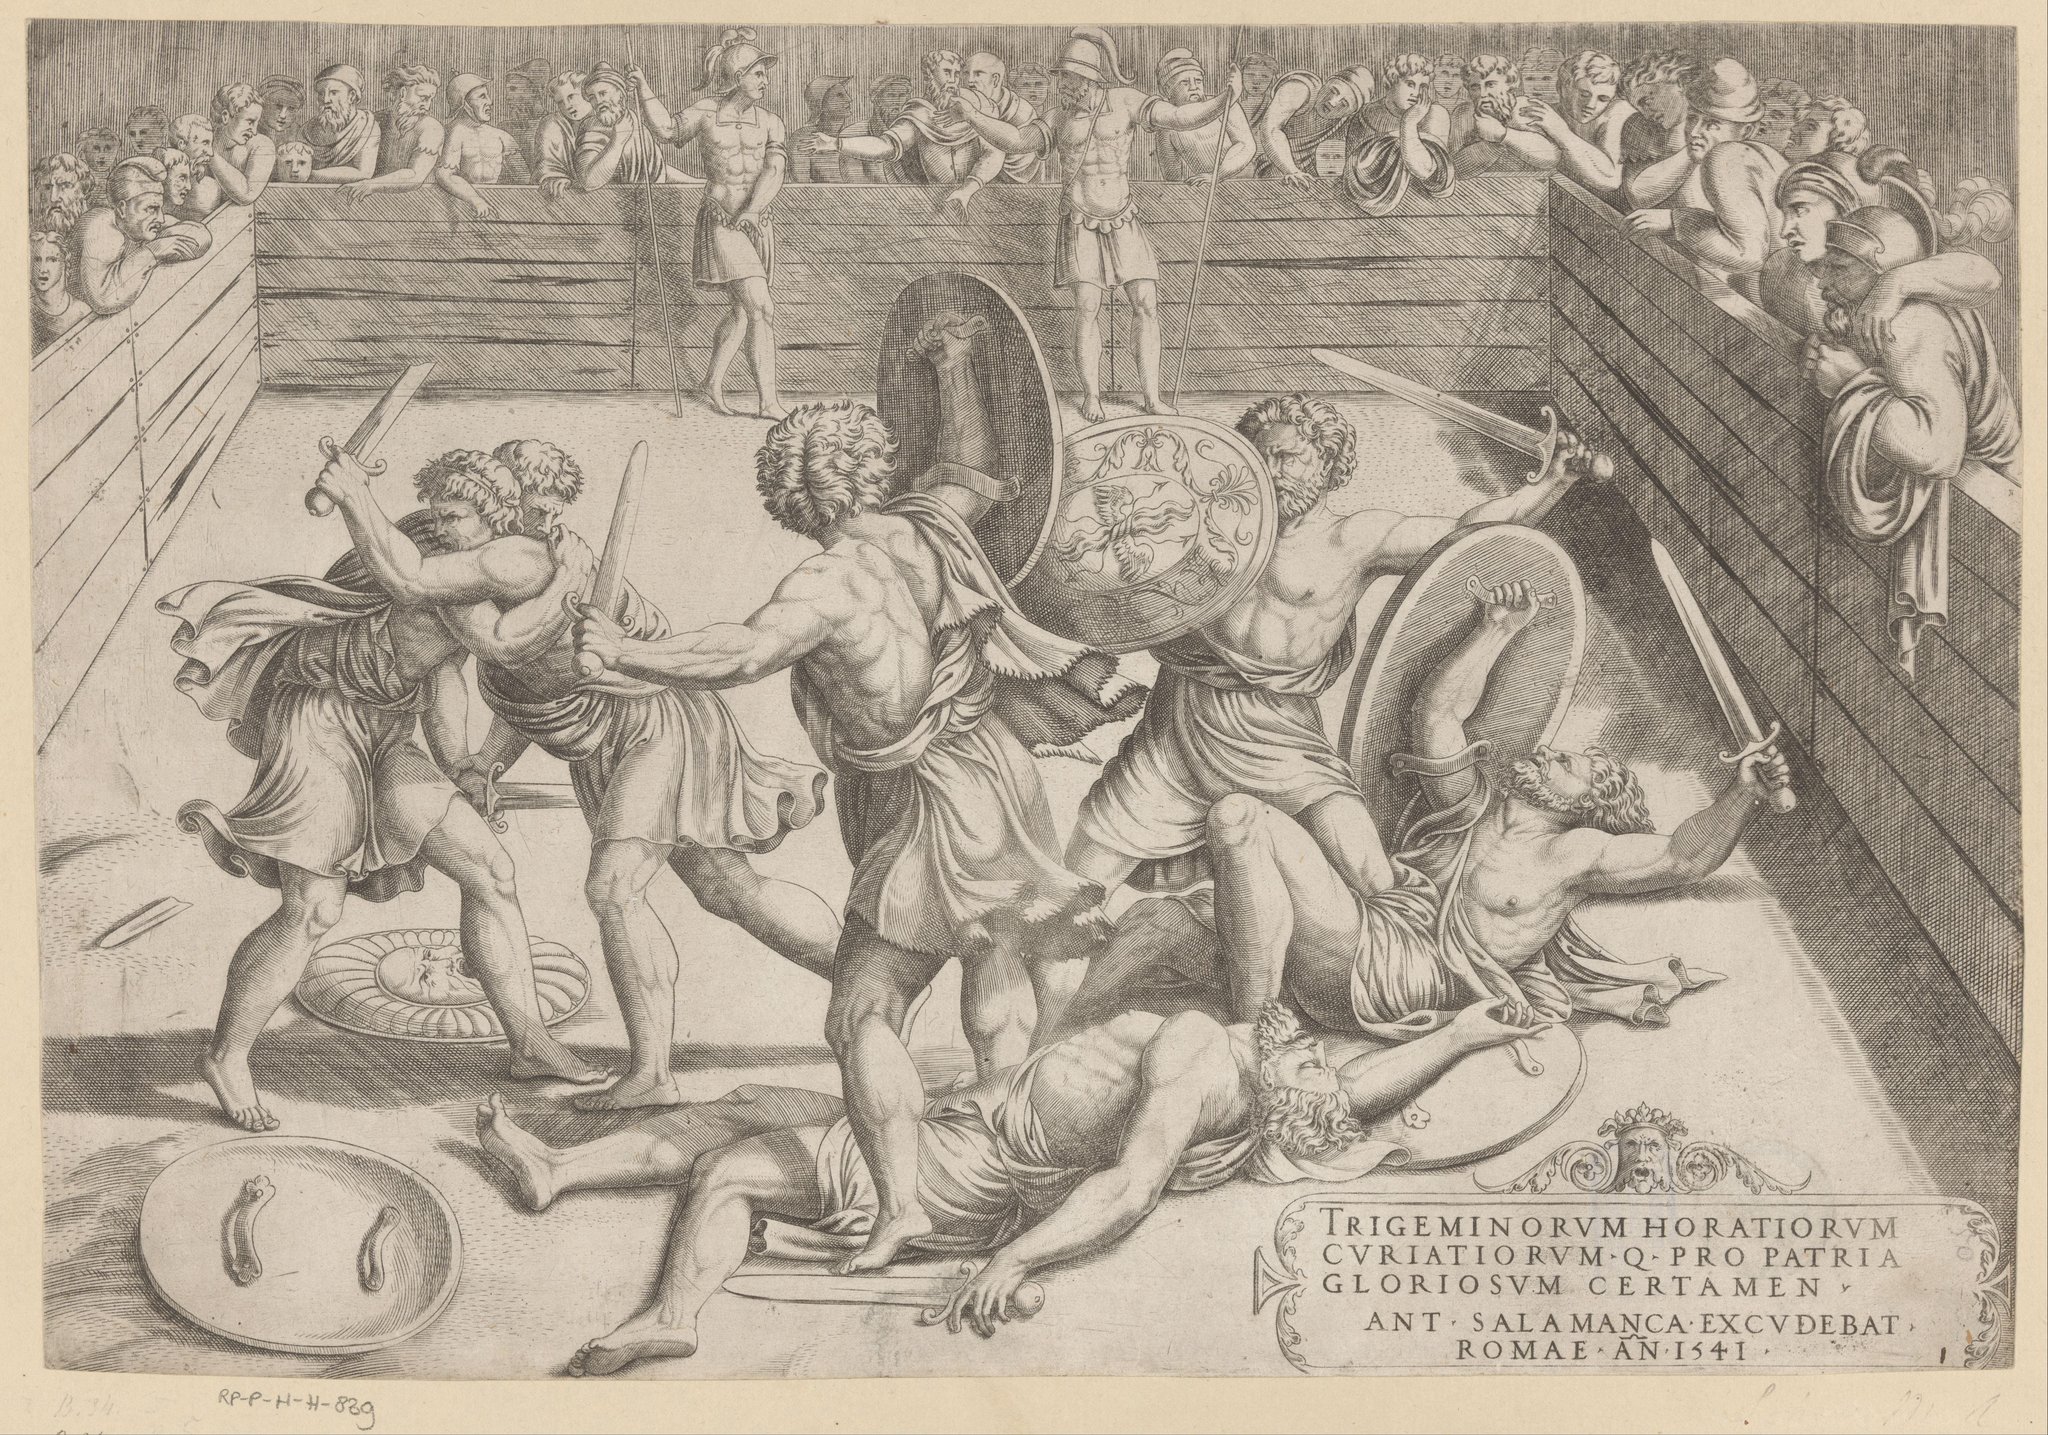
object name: print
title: Strijd tussen de Horatii en de Curatii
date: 1541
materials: paper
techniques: engraving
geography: italy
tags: two horatii being killed, the surviving brother defeats the three curiatii one by one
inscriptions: collector's mark: Lugt 10, collector's mark: Lugt 11, number: ‘1’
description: Duel tussen de Horatii en Curiatii, twee drielingen van respectievelijk Romeinse en Albaanse komaf. Hier doodt Publius Horatius de gewonde Curiatii een voor een. Romeinen moedigen hem aan.